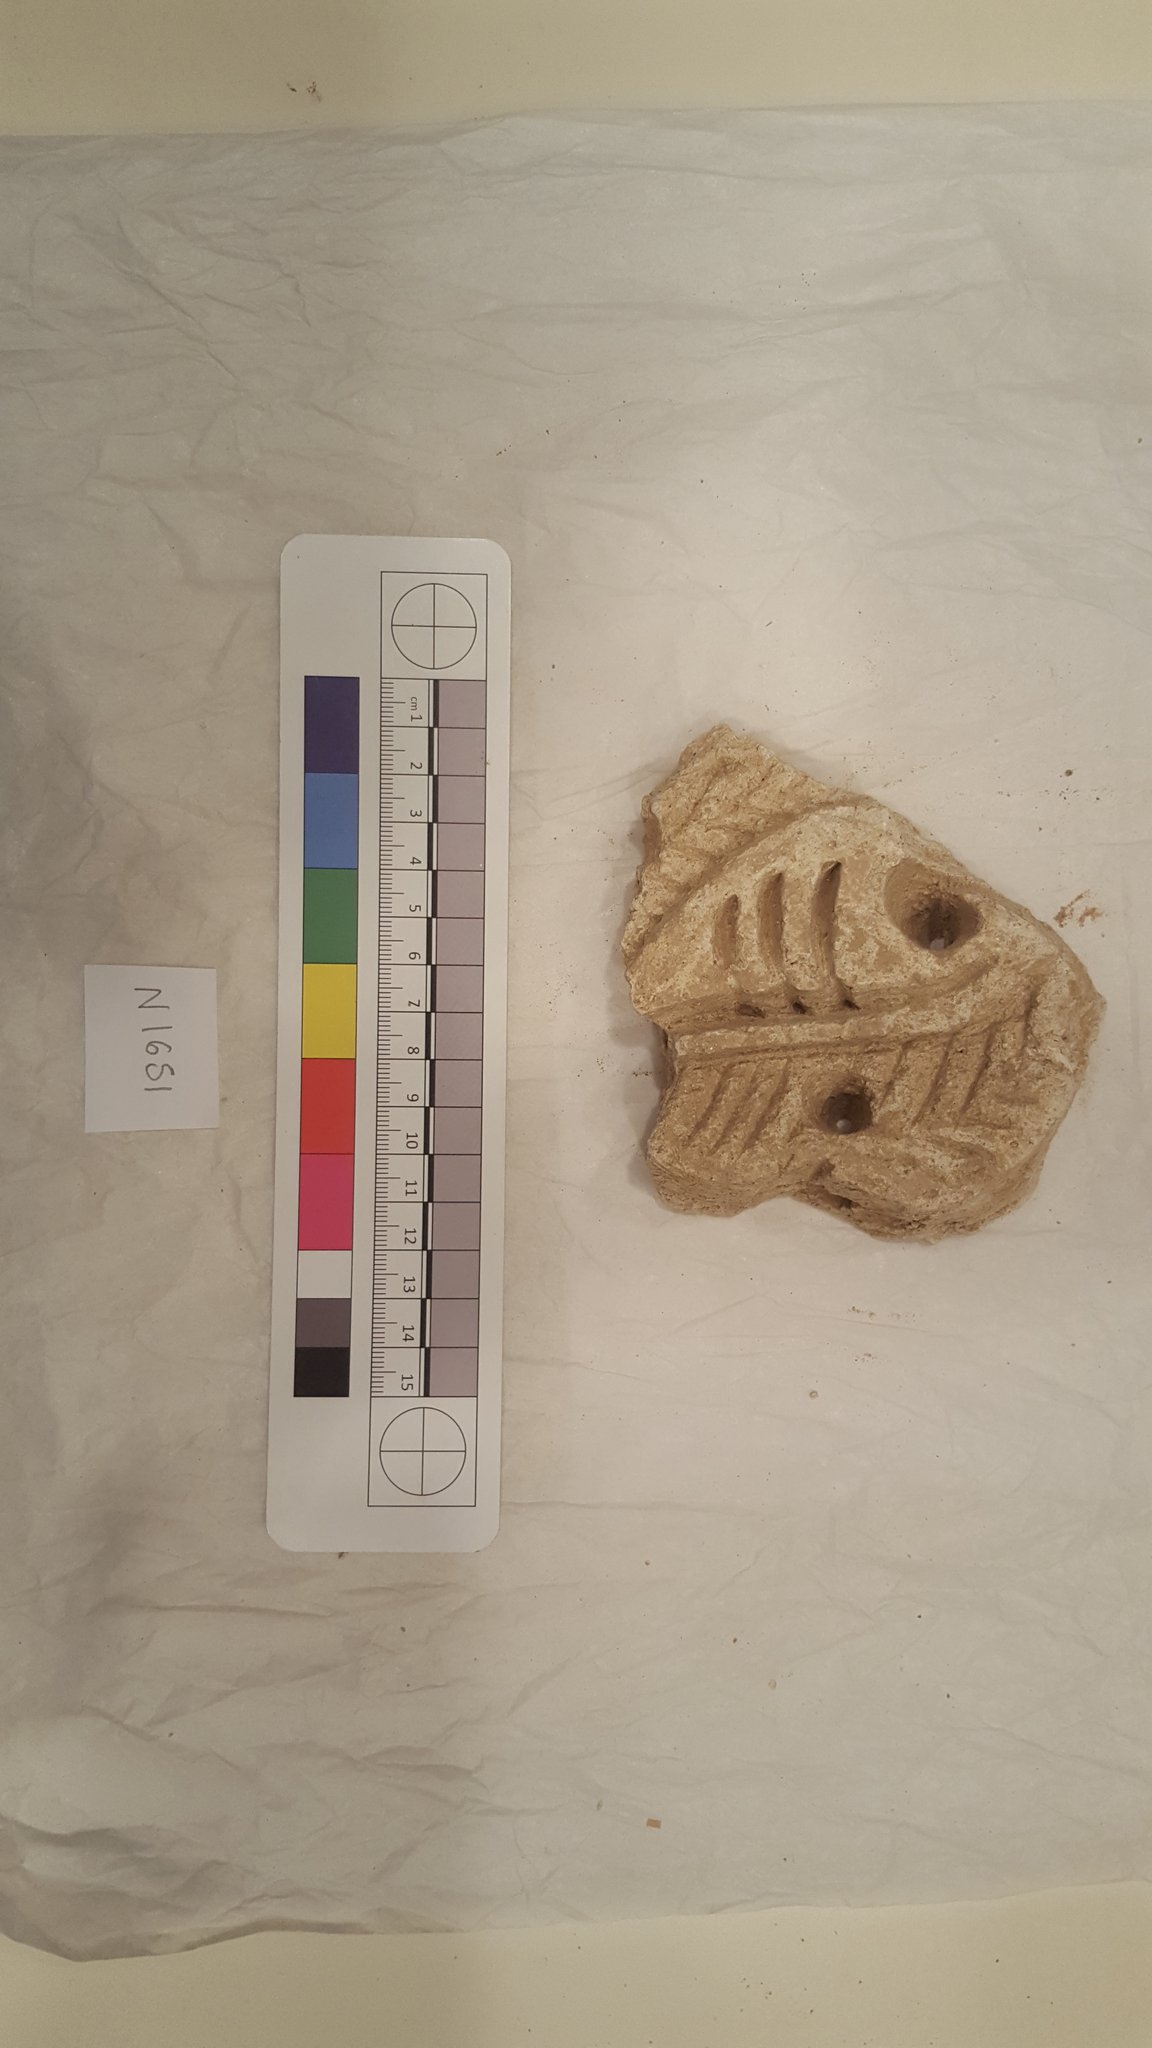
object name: fragment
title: Stucco Fragment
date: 701-1200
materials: plaster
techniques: carving, painting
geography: iran